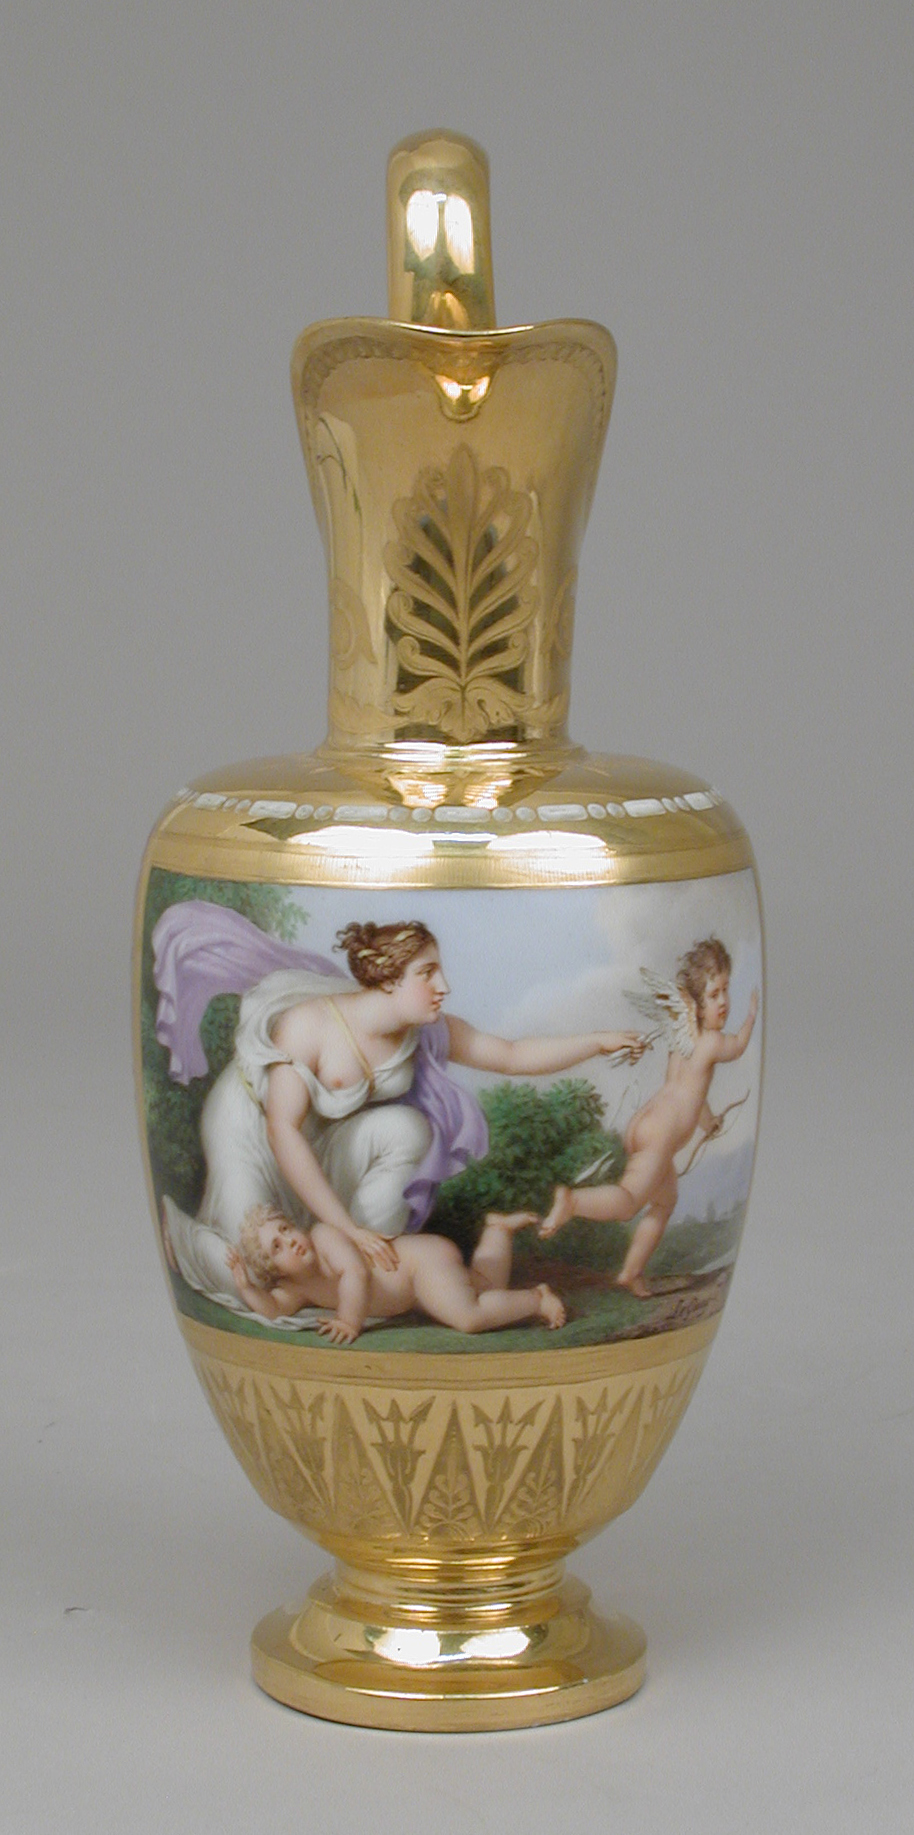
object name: milk jug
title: Milk jug (pot à lait Étrusque), part of Breakfast Service (déjeuner)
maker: sèvres manufactory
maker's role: manufactory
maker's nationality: french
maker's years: 1740-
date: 1813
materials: hard paste porcelain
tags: cupid,nymphs